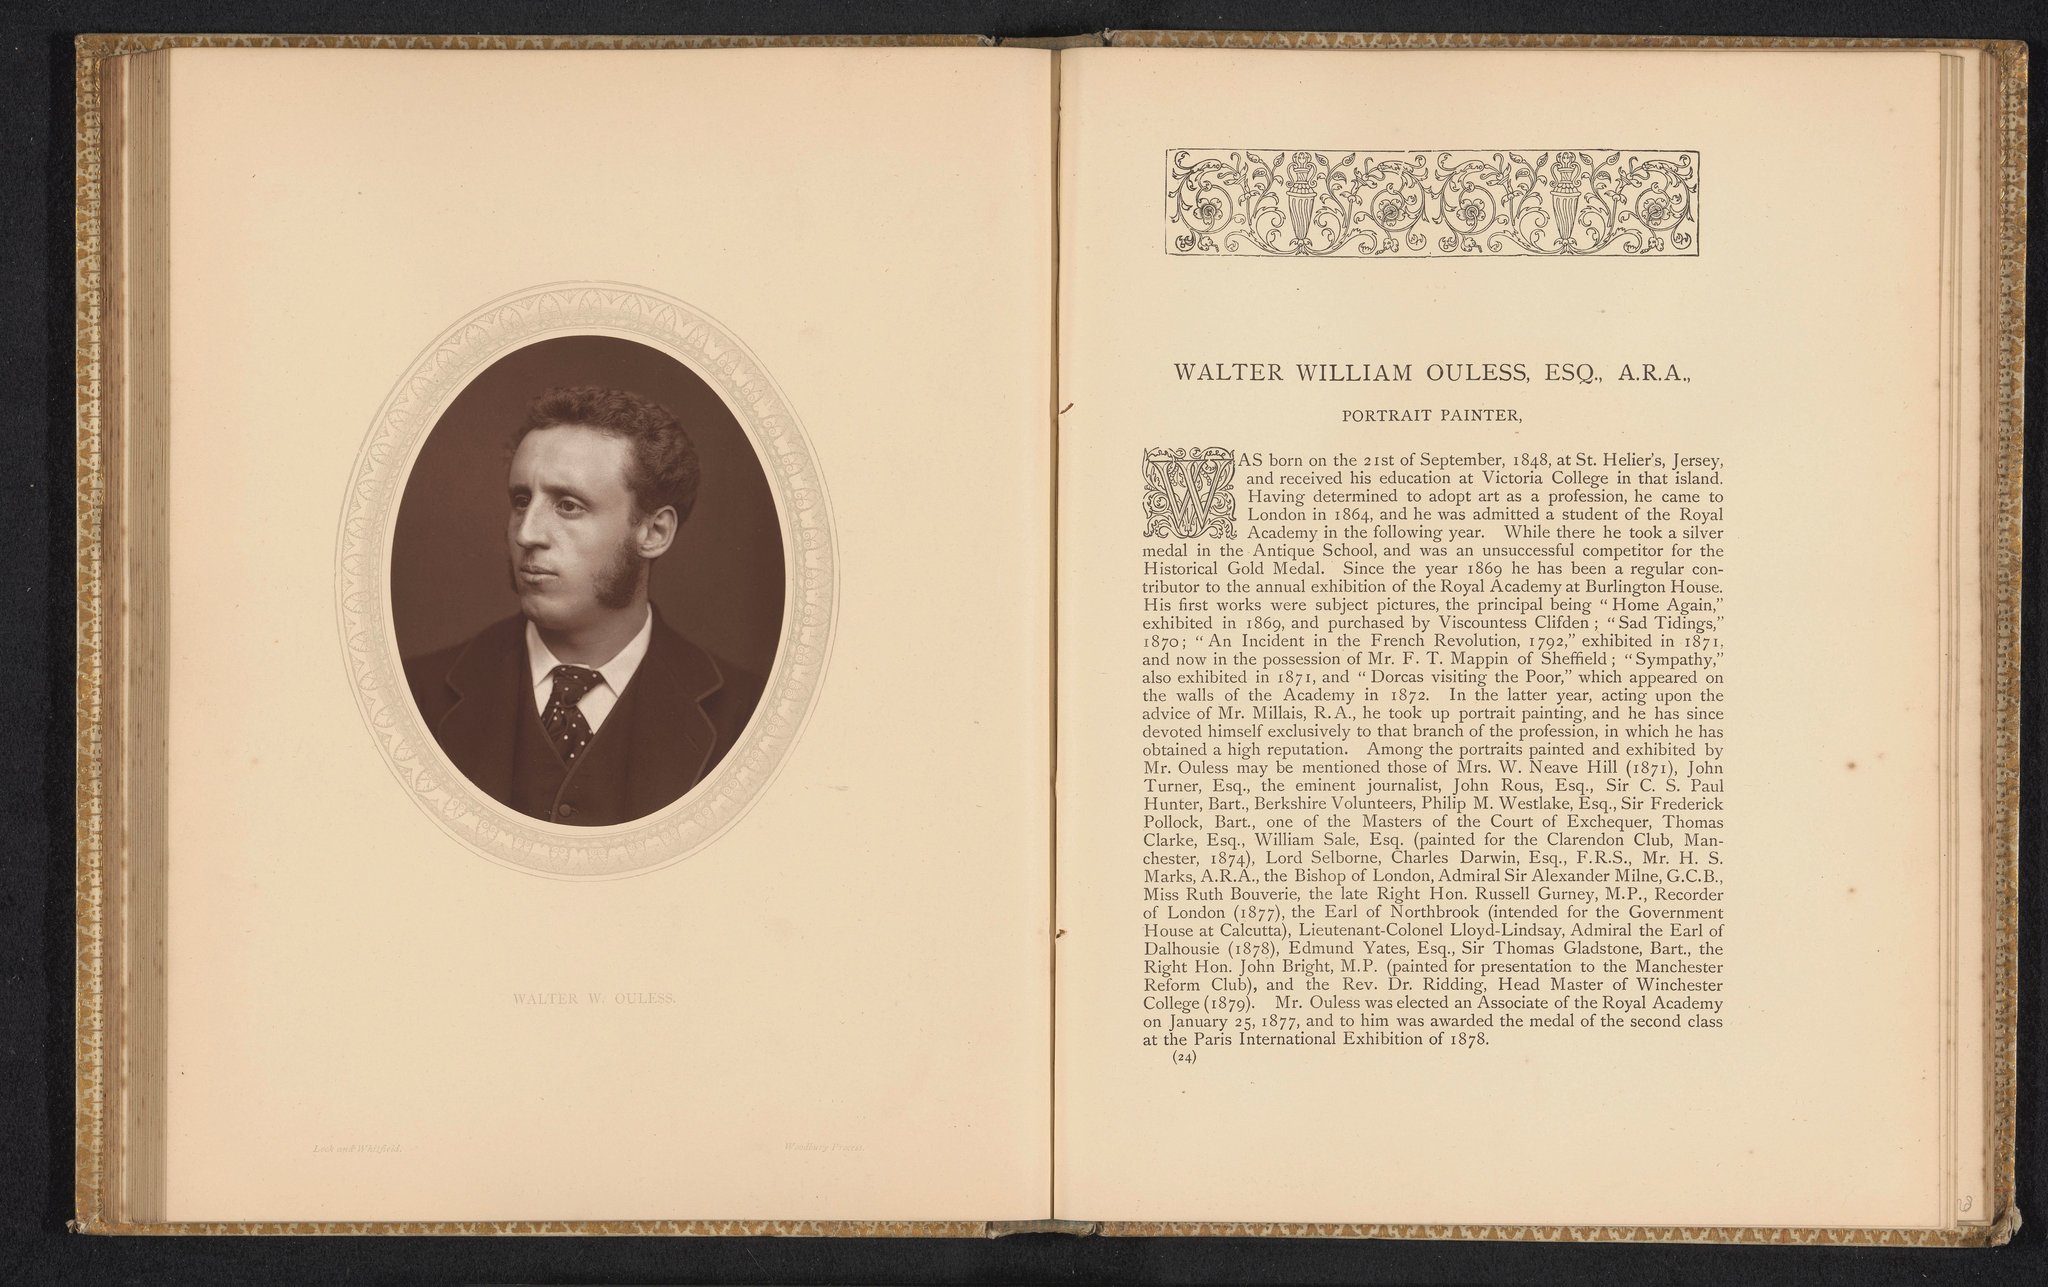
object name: page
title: Walter W. Ouless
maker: Anonymous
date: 1875-1880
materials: paper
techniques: woodburytype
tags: painter, portrait, self-portrait of painter, historical persons (portraits and scenes from the life) (+ (full) bust portrait)